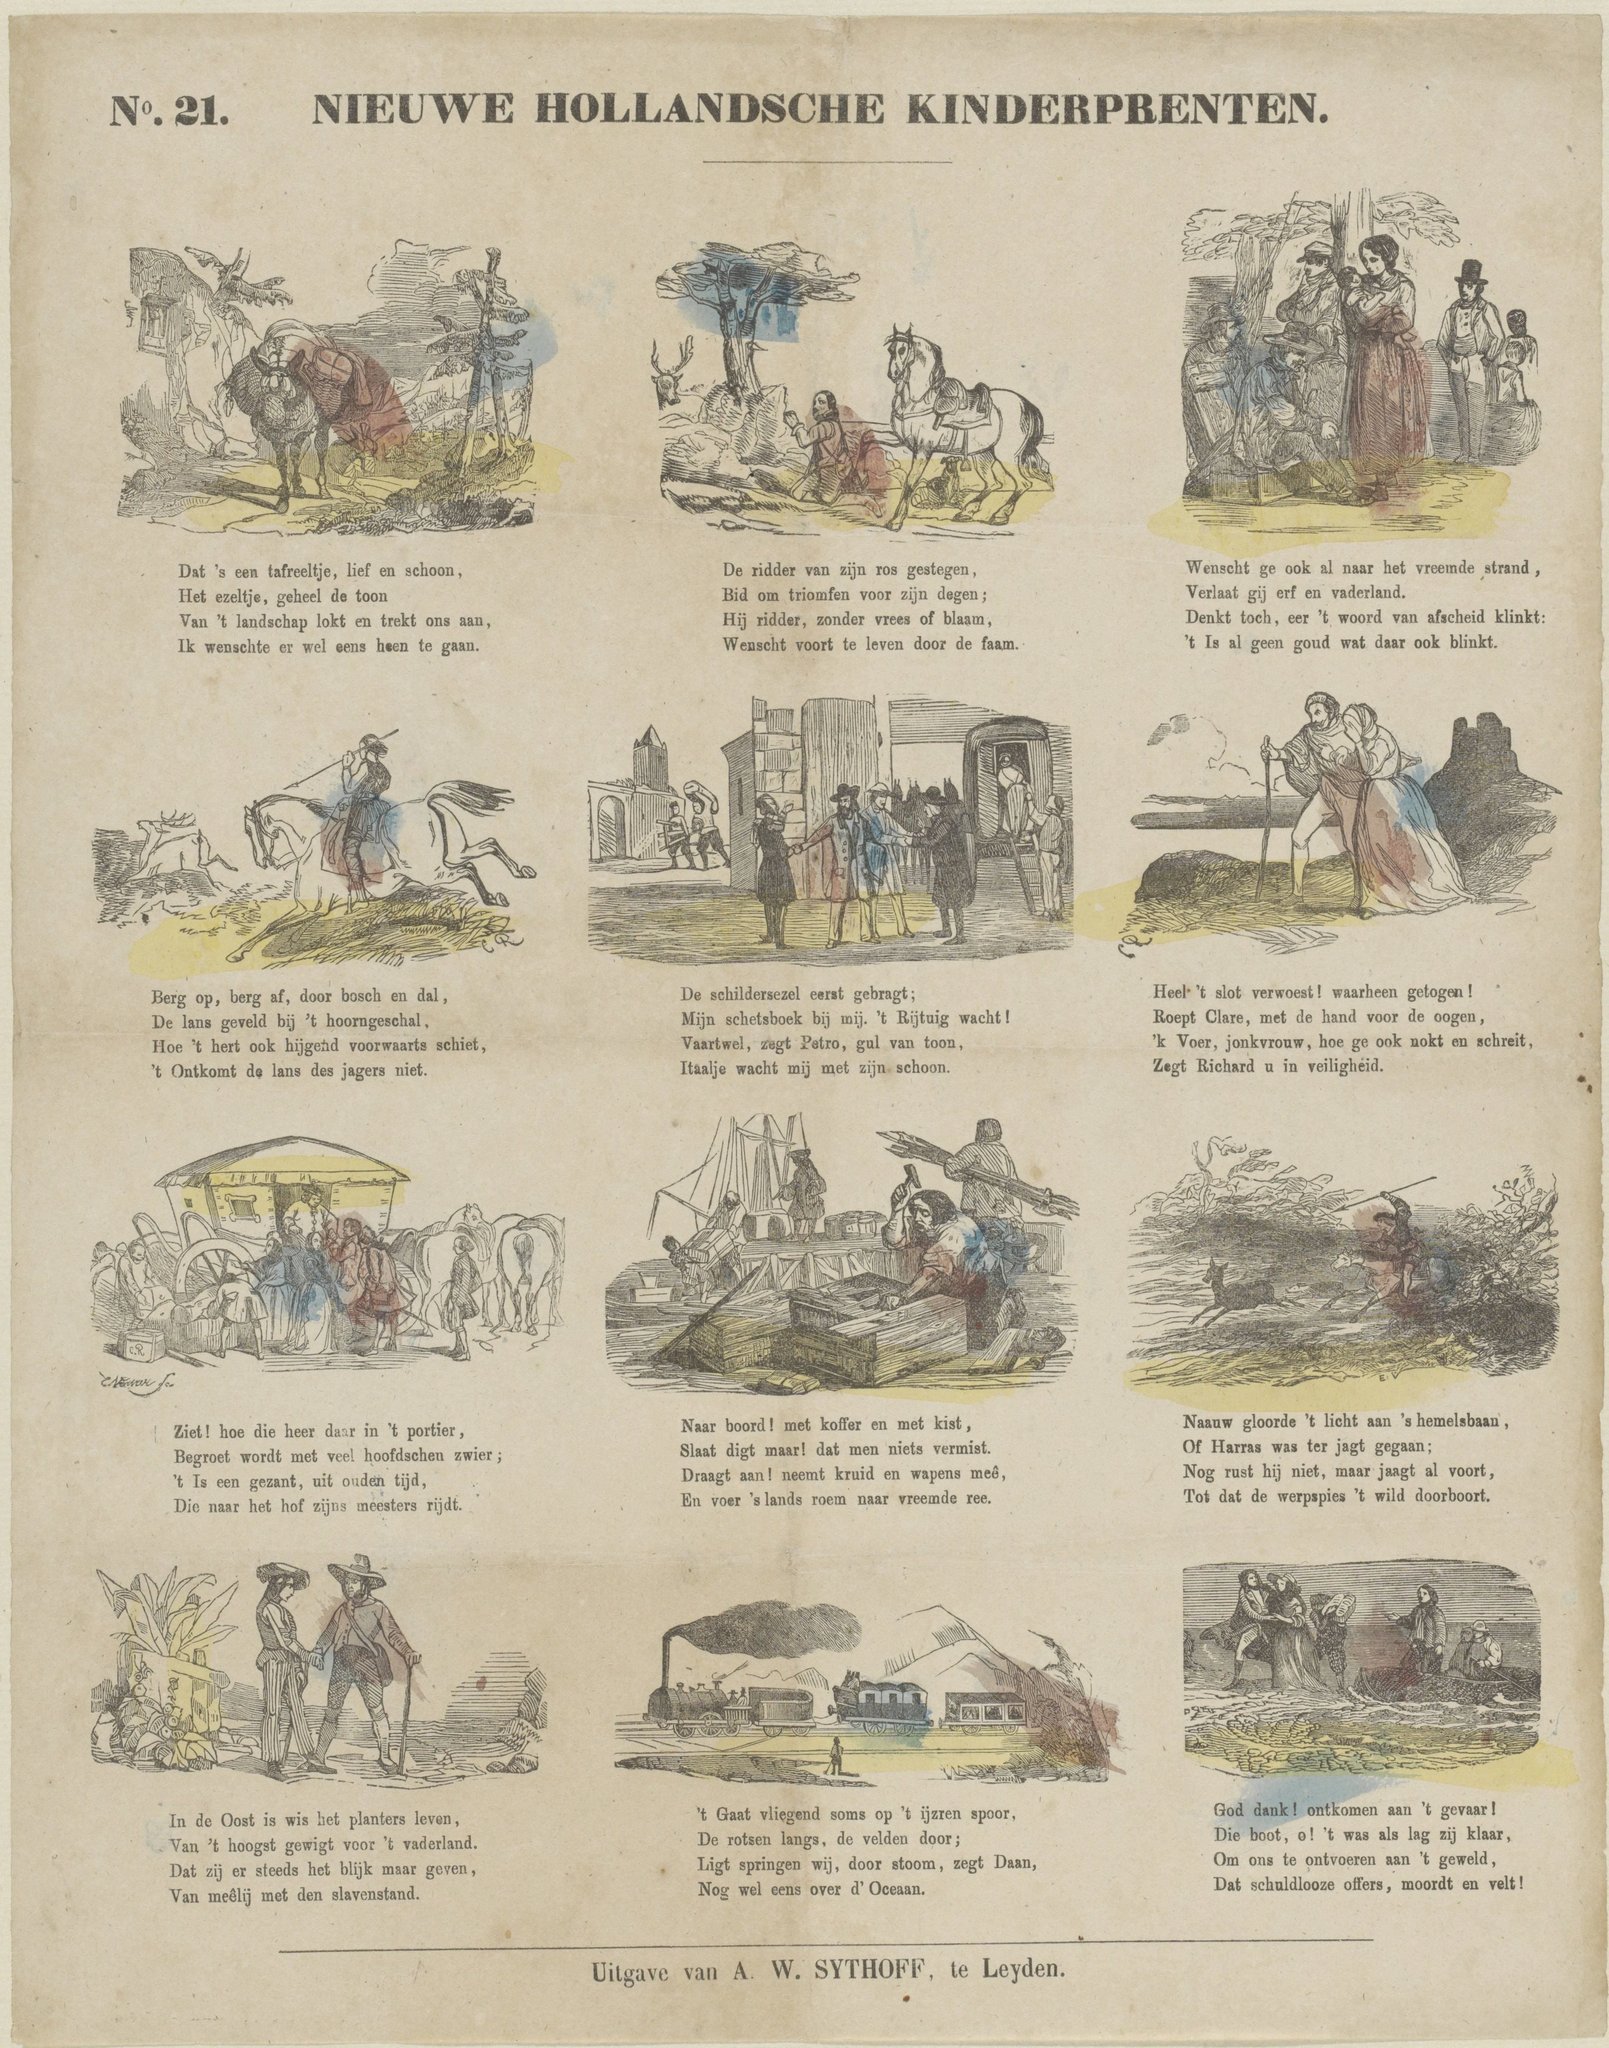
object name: popular print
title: Nieuwe Hollandsche kinderprenten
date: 1861-1929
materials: paper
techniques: colour, letterpress printing, engraving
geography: leiden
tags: ass, donkey, hunter, hunters hunting (n.b.: in 1988-1990 this notation denoted the concept of 43c11421 'hunters resting during the hunt'), steam locomotive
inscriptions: collector's mark: Lugt 2760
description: Blad met 12 voorstellingen van verschillende aard, zoals voorstellingen van een pakezel, van een jager te paard en van een stoomtrein. Onder elke voorstelling een vierregelig vers. Genummerd linksboven: No. 21.